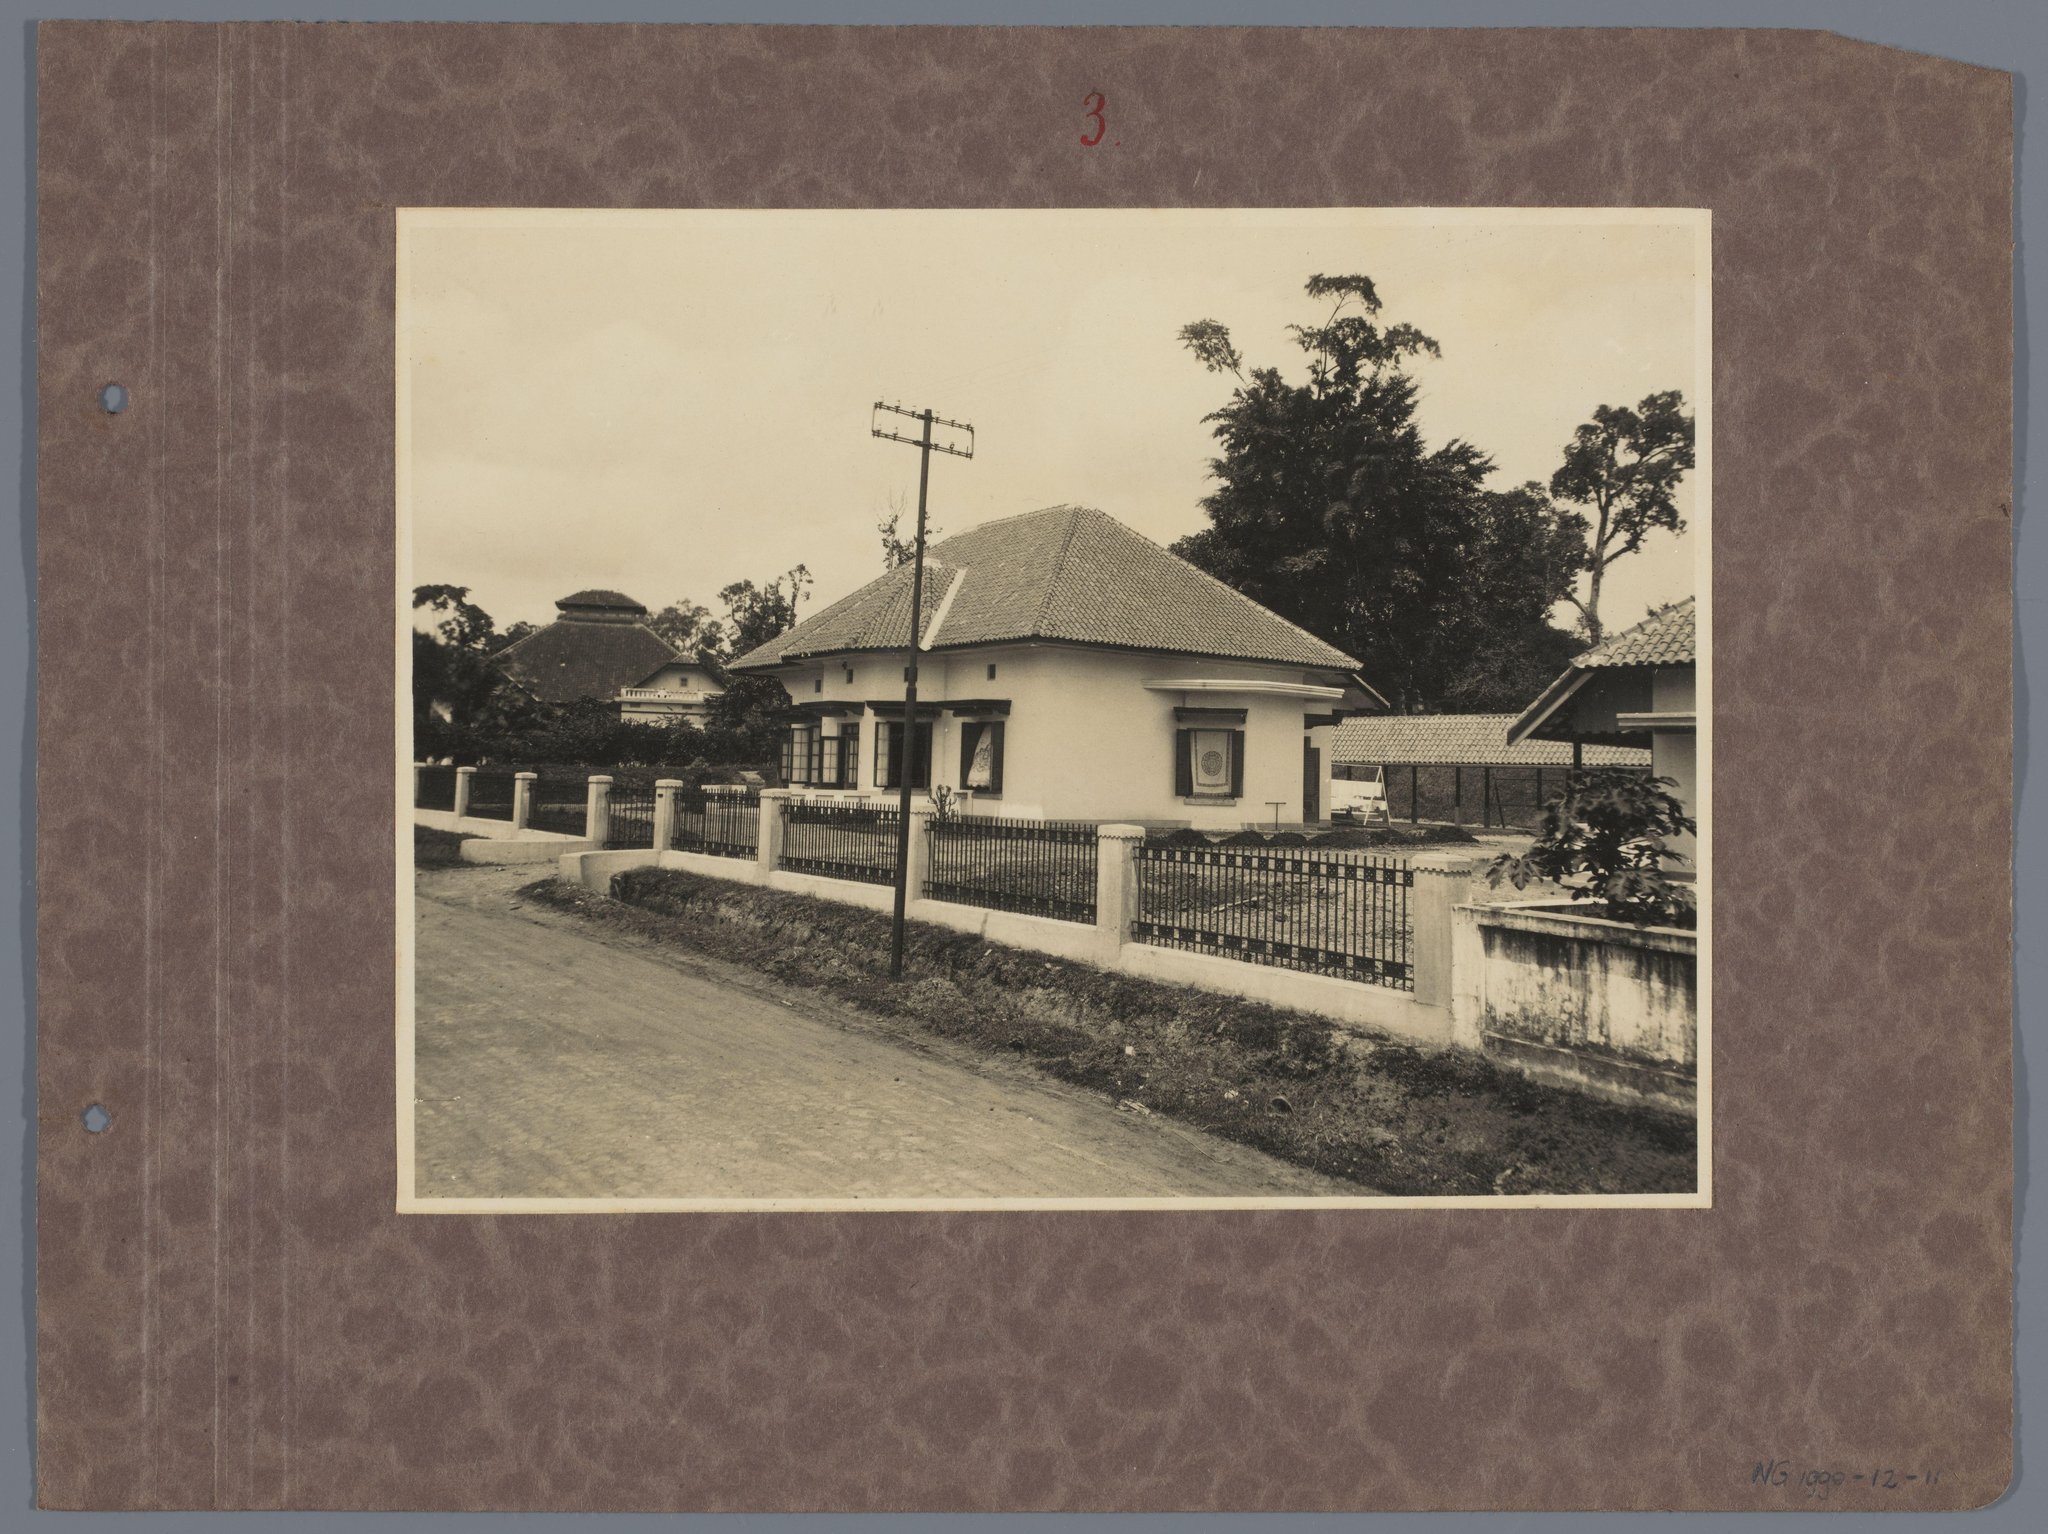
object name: photograph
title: Woonhuis met hek en tuin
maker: Anonymous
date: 1900-1940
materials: cardboard, photographic support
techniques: gelatin silver print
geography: sumatra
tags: sumatra, dutch east indies, the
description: Gezicht op een woonhuis met hek en tuin. Foto opgeplakt op een albumblad genomen uit een fotoalbum. Onderdeel van een groep van 14 losse foto's genomen op Midden- en Zuid-Sumatra in de periode ca. 1900-1940.